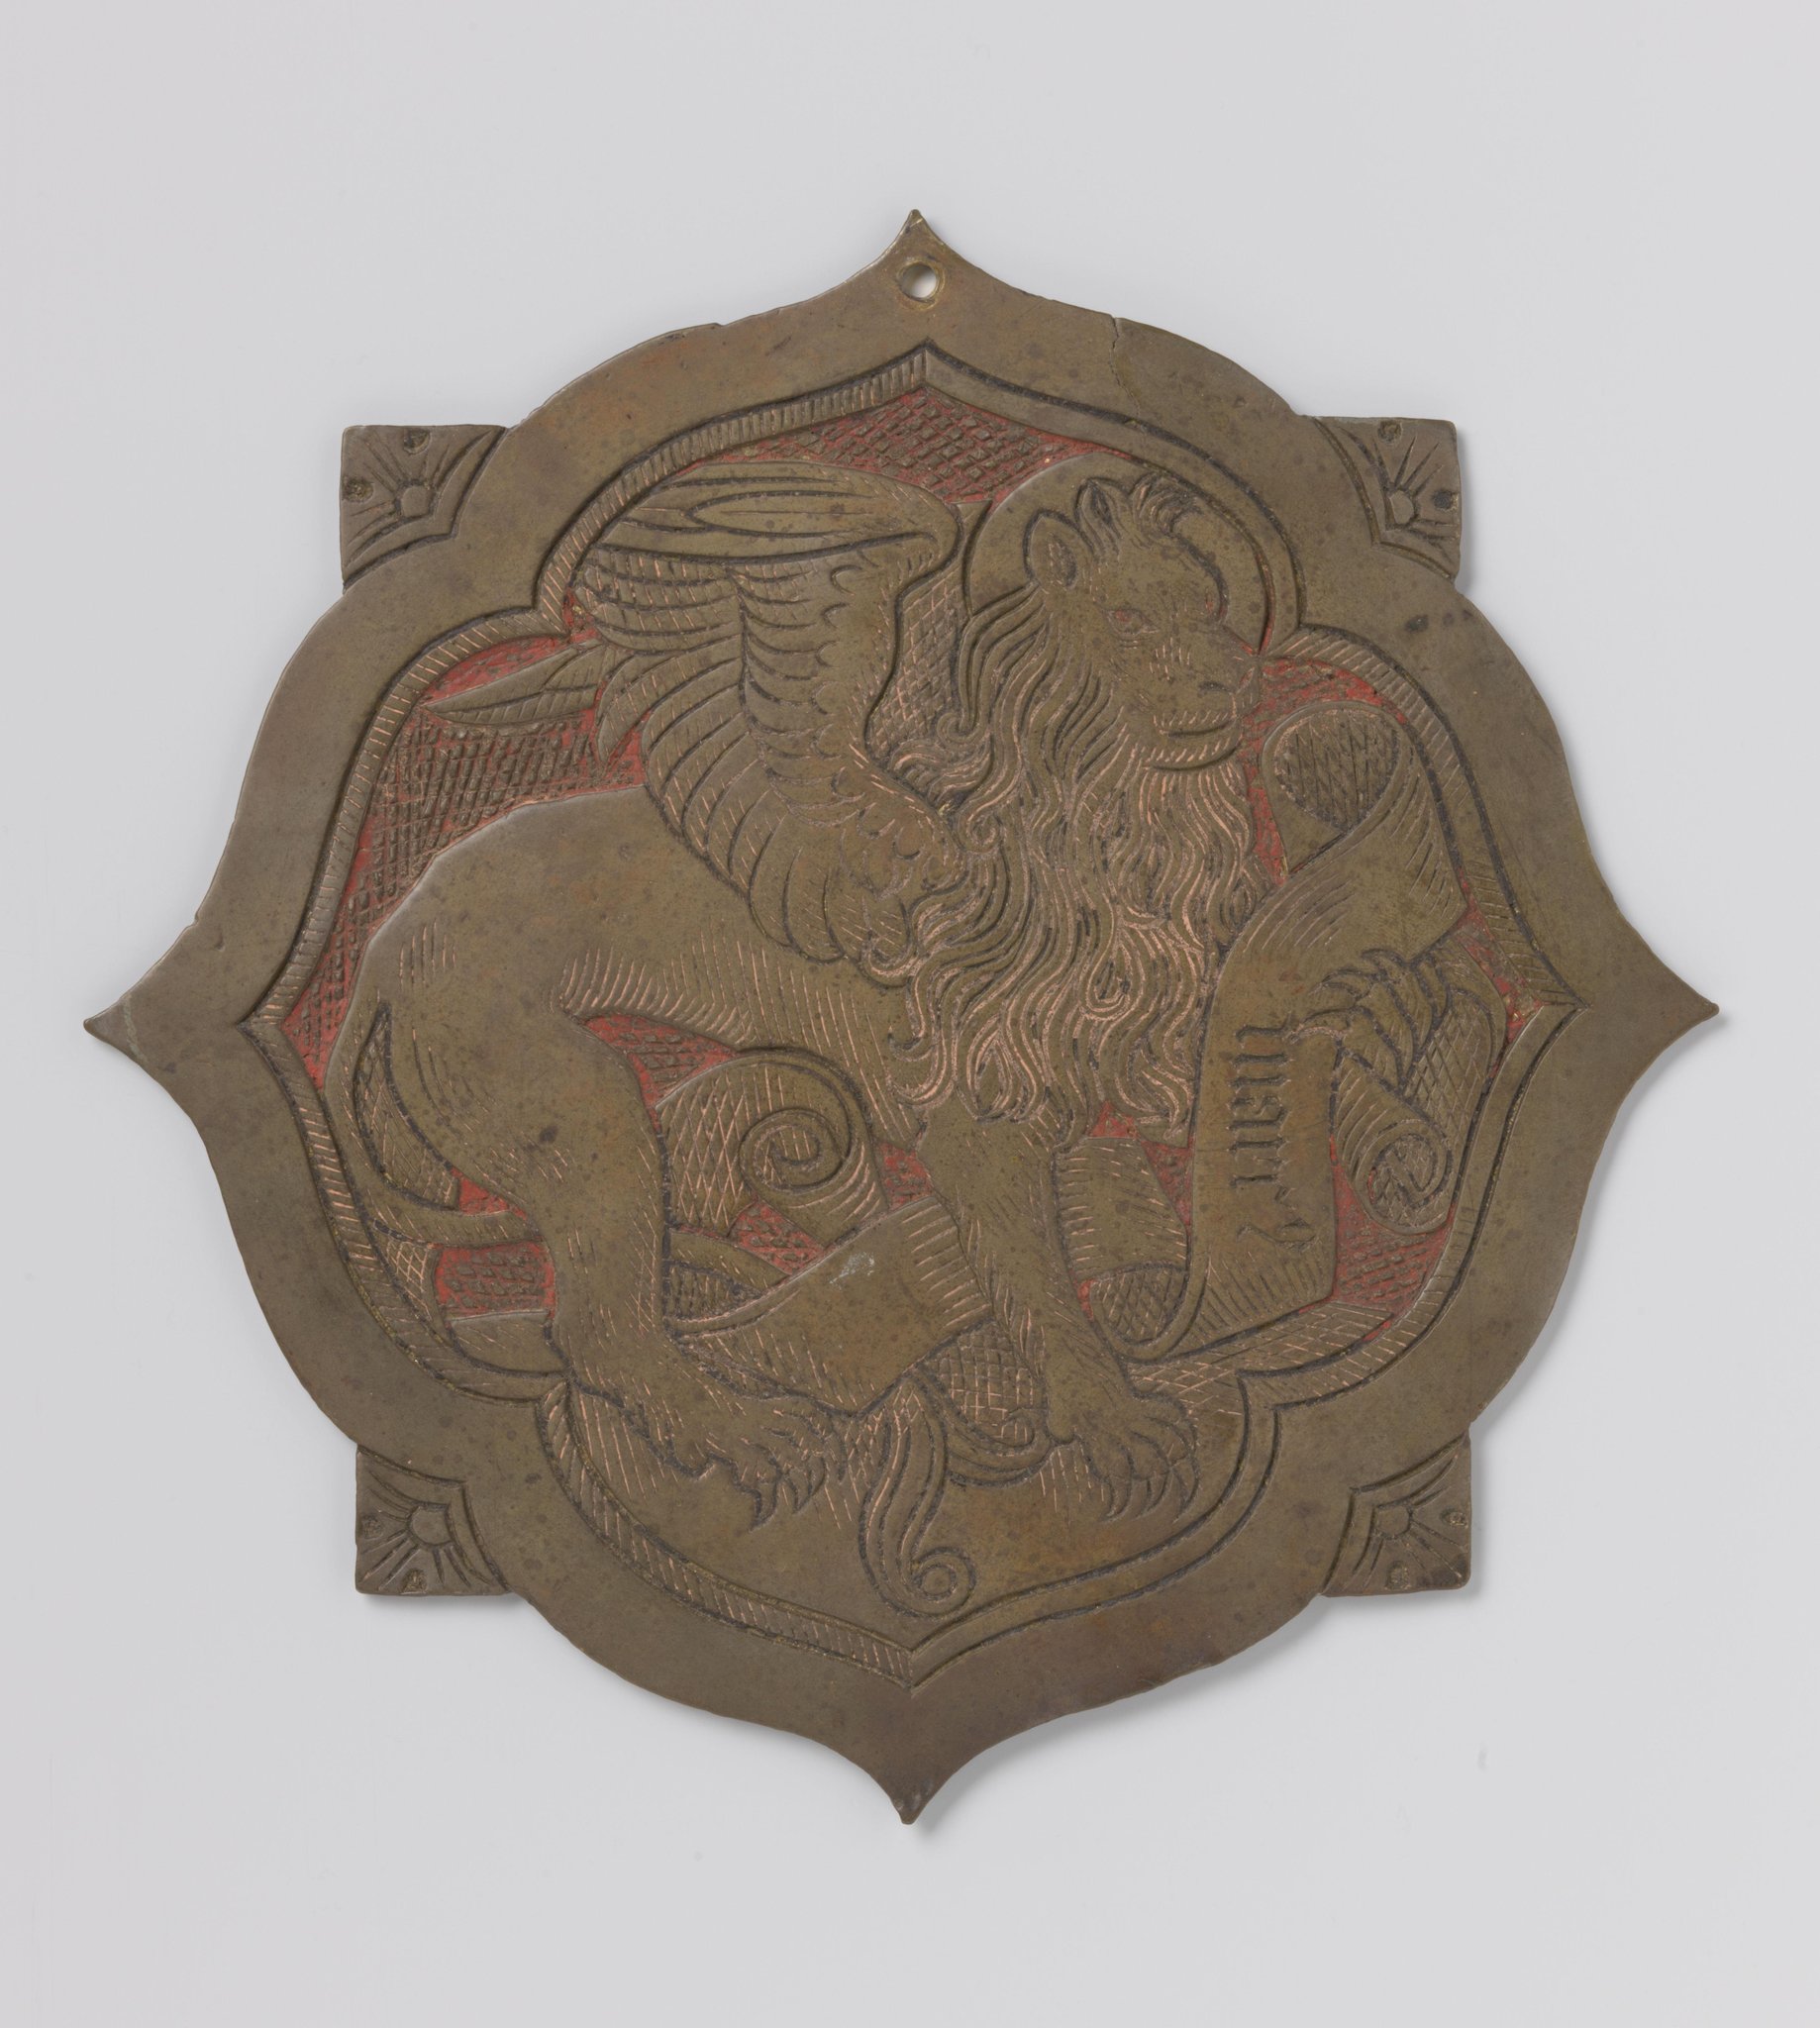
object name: grafzerk, zerk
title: Corner Plates of the Tombstone of Gijsbert Willemsz Raet, with the Four Evangelists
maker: Anonymous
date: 1511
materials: brass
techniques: casting, cutting, engraving, gilding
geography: low countries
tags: mark (marcus) the evangelist, and bishop of alexandria; possible attributes: book, (winged) lion, pen and inkhorn, scroll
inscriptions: inscription: ‘marcs’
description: These four corner plates feature the symbols of the Four Evangelists: a winged lion (Mark), a winged ox (Luke), an eagle (John) and an angel (Matthew). The influence of printmaking – and specifically of Martin Schongauer – on other art forms is clear to see here. Slight differences notwithstanding, the maker was certainly inspired by either Schongauer’s engravings or copies thereof, or objects based on those prints.